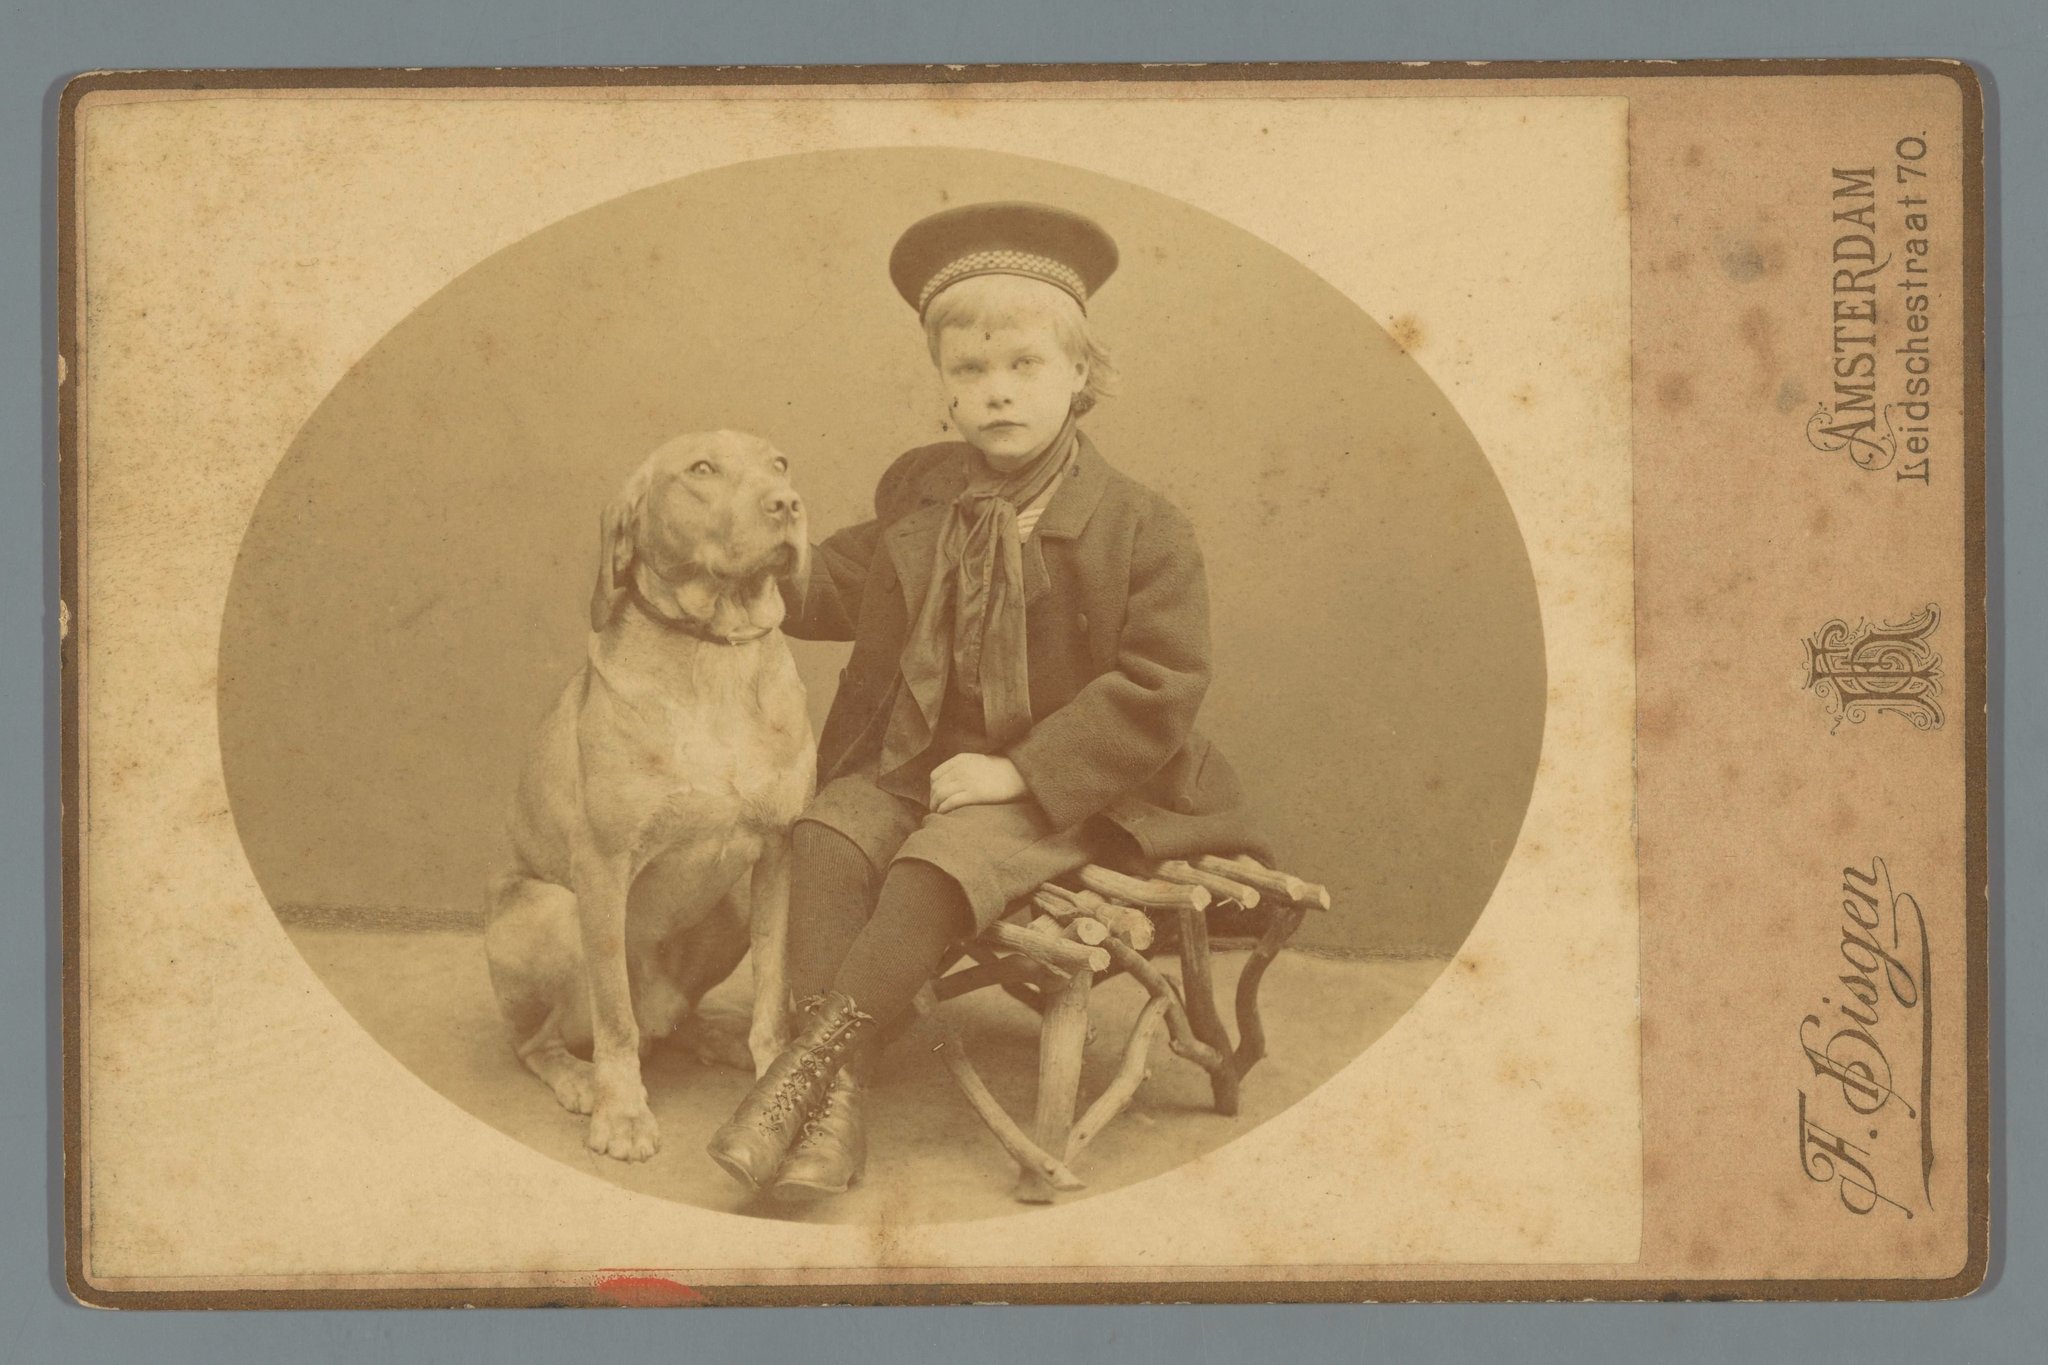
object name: cabinet photograph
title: Portret van een onbekend kind met een hond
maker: friedrich carel hisgen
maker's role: fotograaf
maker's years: 1846-1912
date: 1888-1891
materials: cardboard, photographic support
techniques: albumen print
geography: amsterdam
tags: studio requisites ~ photographer, child, dog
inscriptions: name: ‘American Photography F. Hisgen Amsterdam, Leidschestraat 70.’